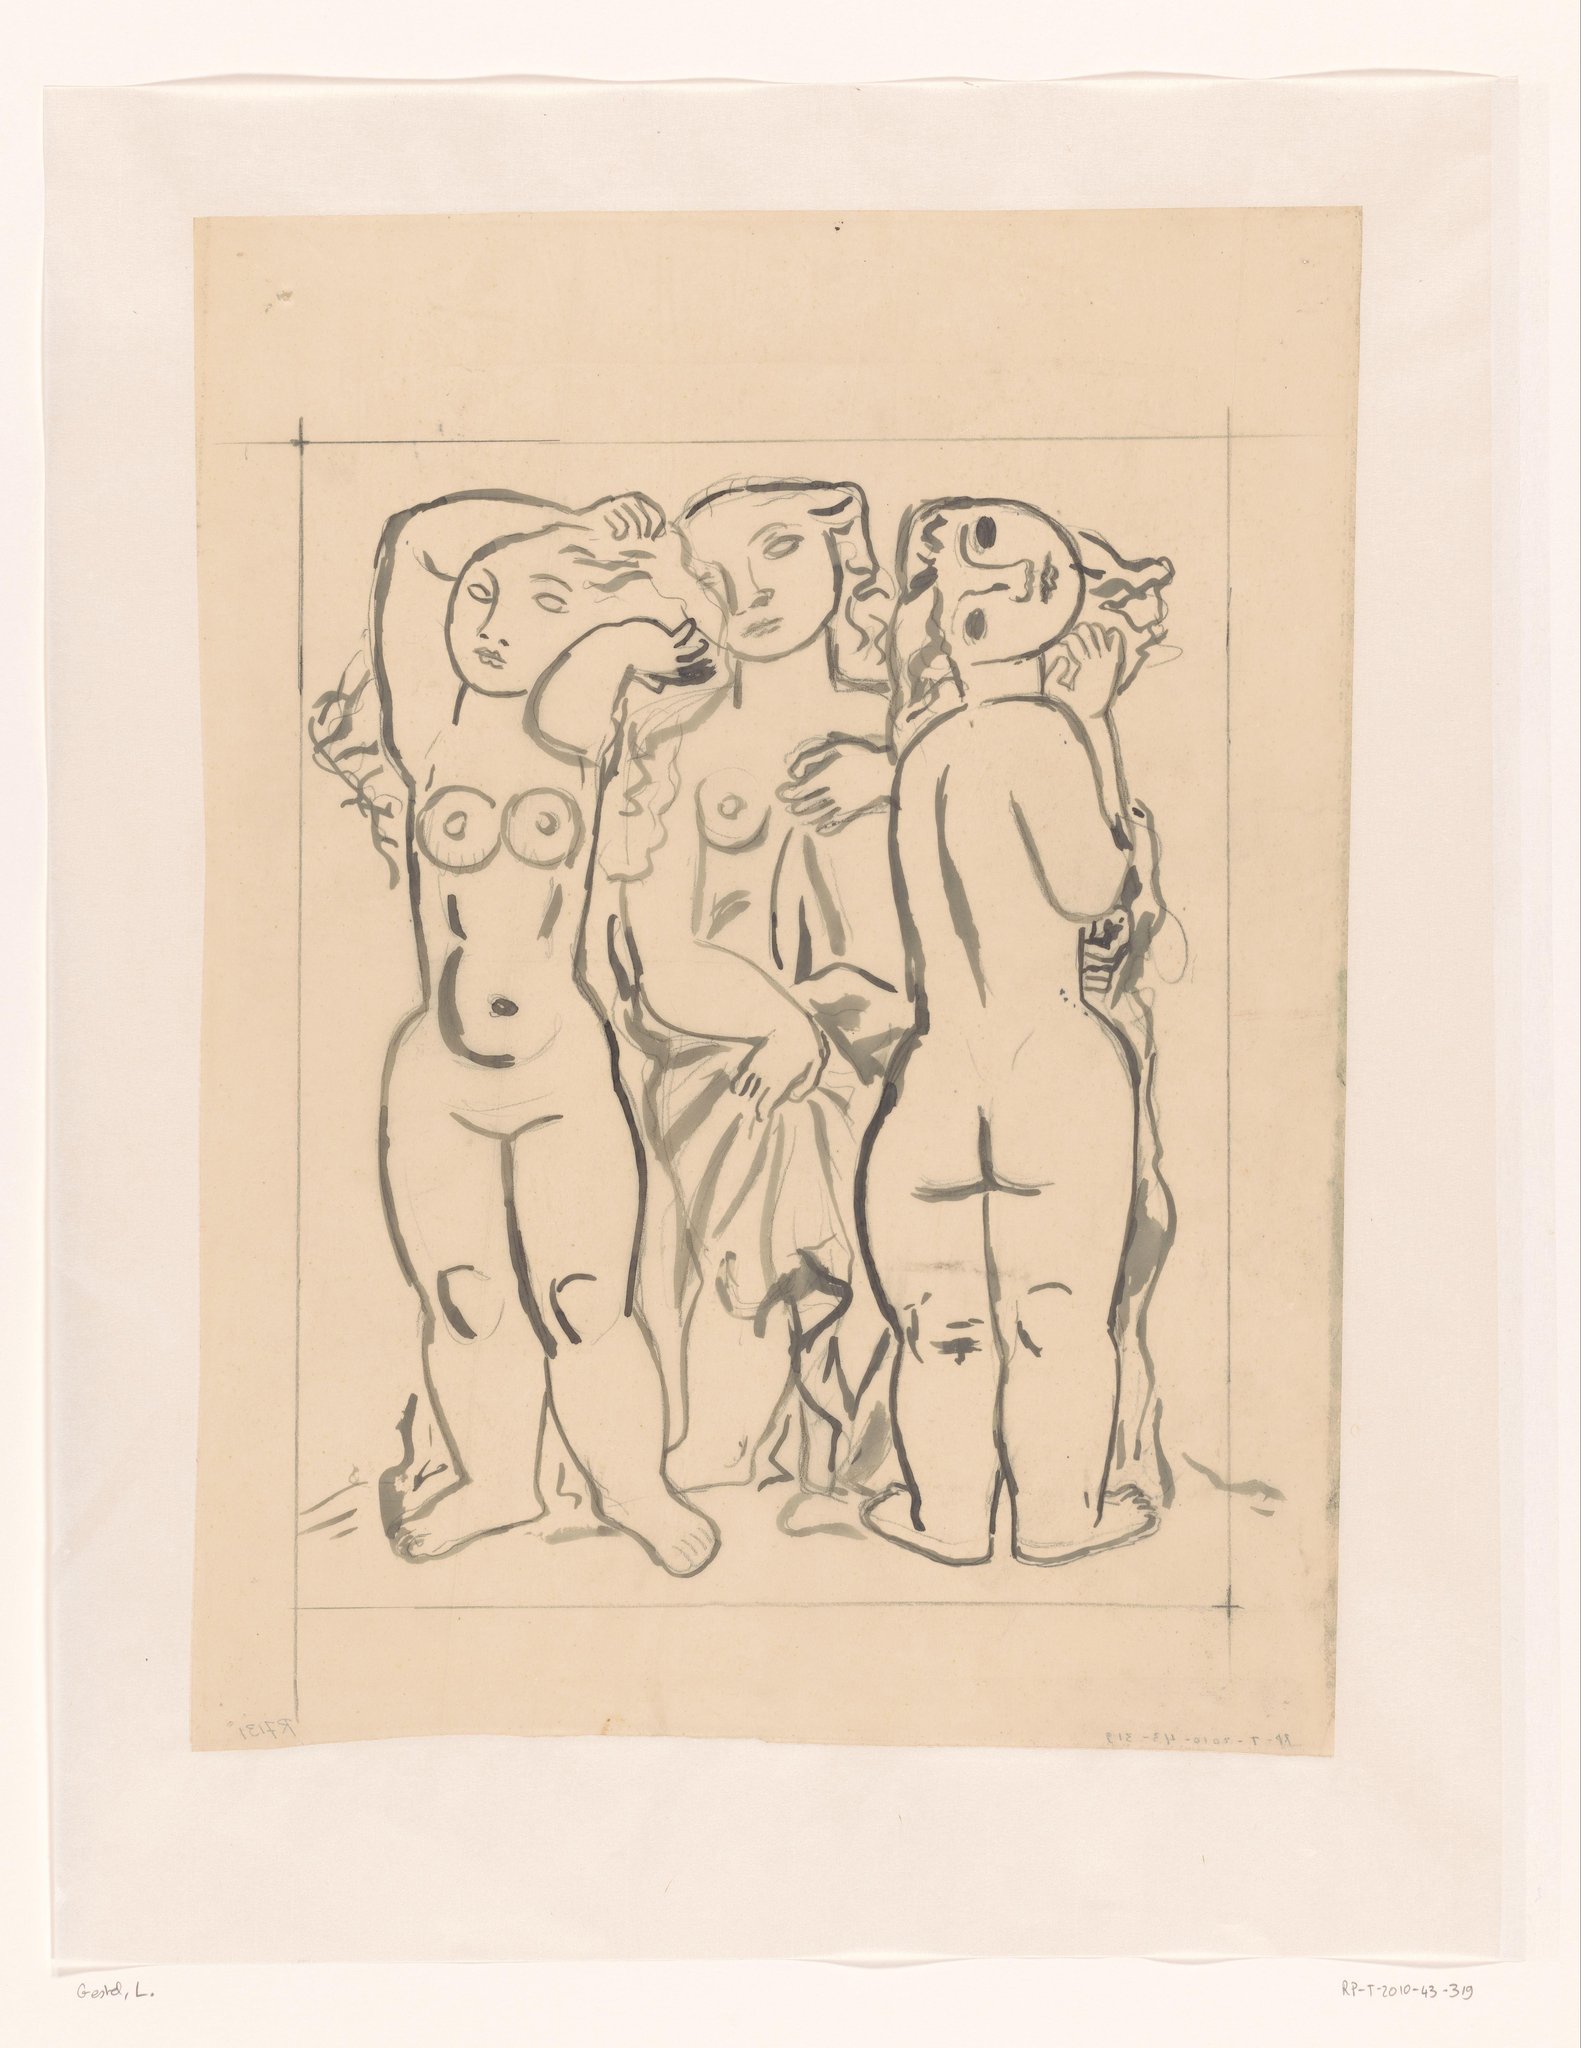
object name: drawing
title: Drie gratiën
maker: leo gestel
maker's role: draughtsman, print maker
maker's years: 1881-1941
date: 1931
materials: ink, pencil, paper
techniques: brush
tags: graces (charites), generally three in number; 'gratie' (ripa)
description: Drie staande naakte vrouwen, de middelste met een doek om haar middel gedrapeerd, de rechter op de rug gezien.